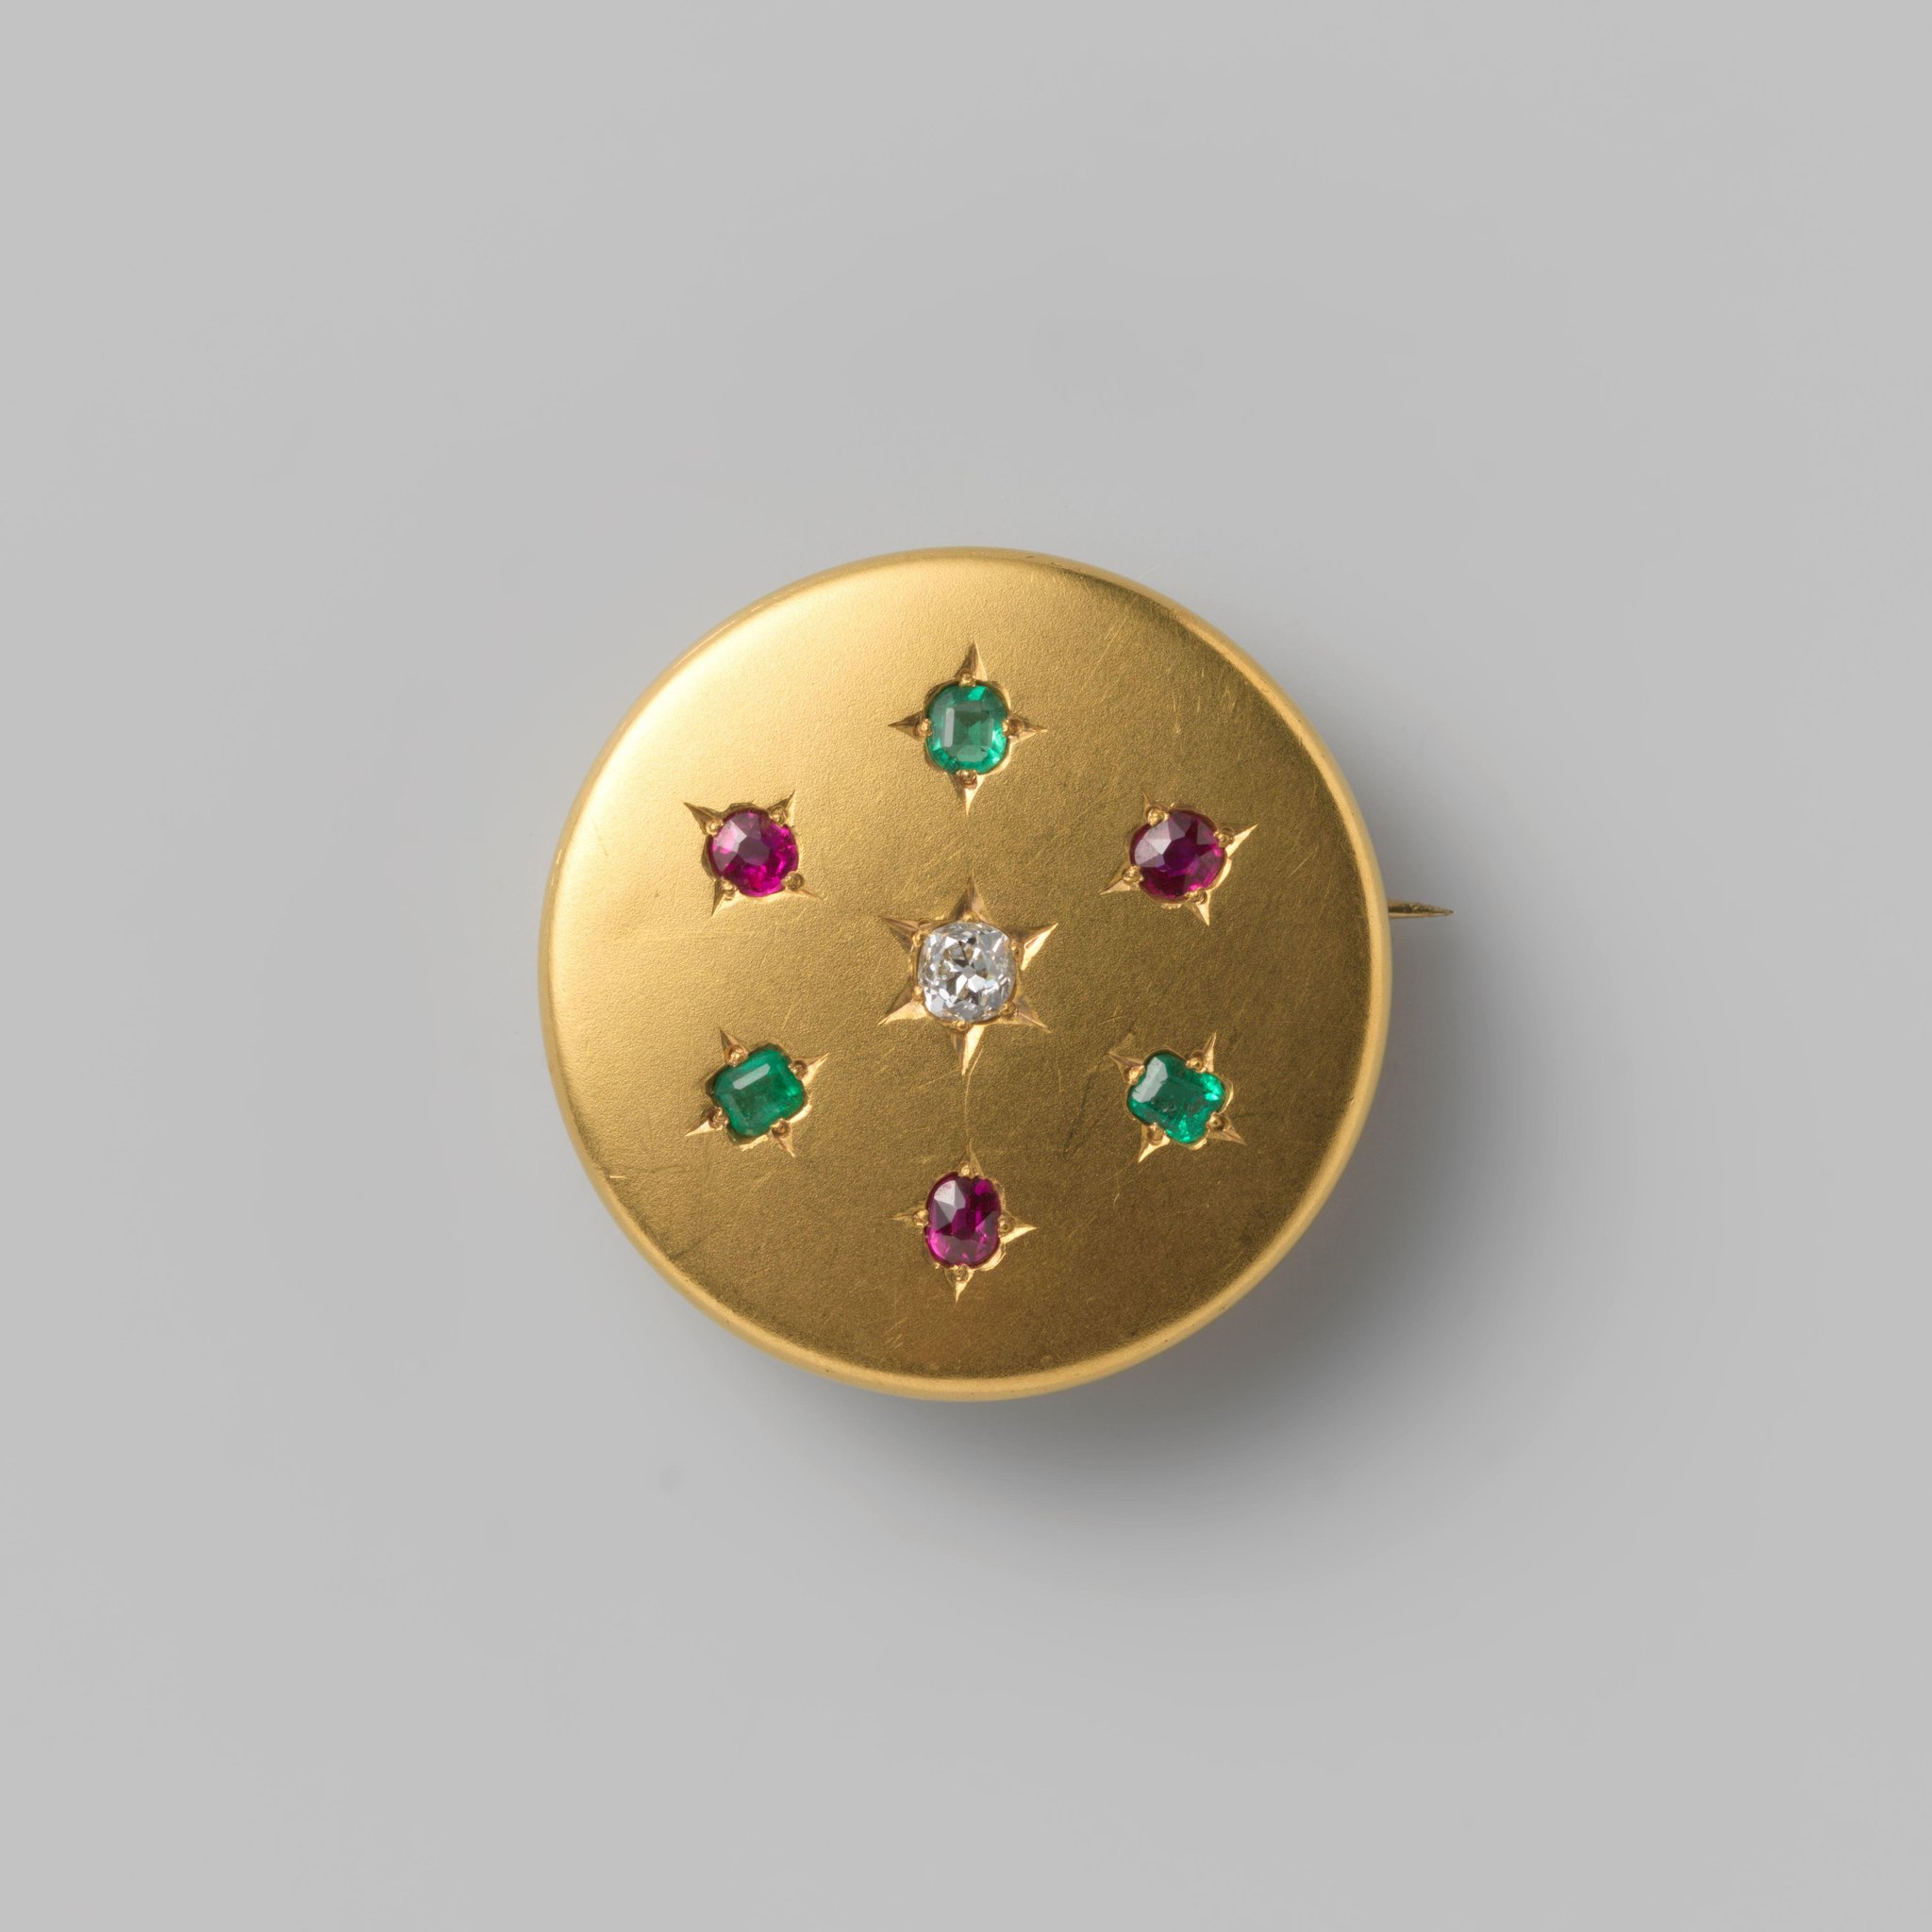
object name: jewellery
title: Broche van goud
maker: Anonymous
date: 1800-1900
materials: diamond, gemstone, gold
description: Ronde, schijfvormige broche van dof goud. Bezet met in het midden een diamant en daaromheen 3 robijnen en 3 smaragden, allen in een stervormige zetting.